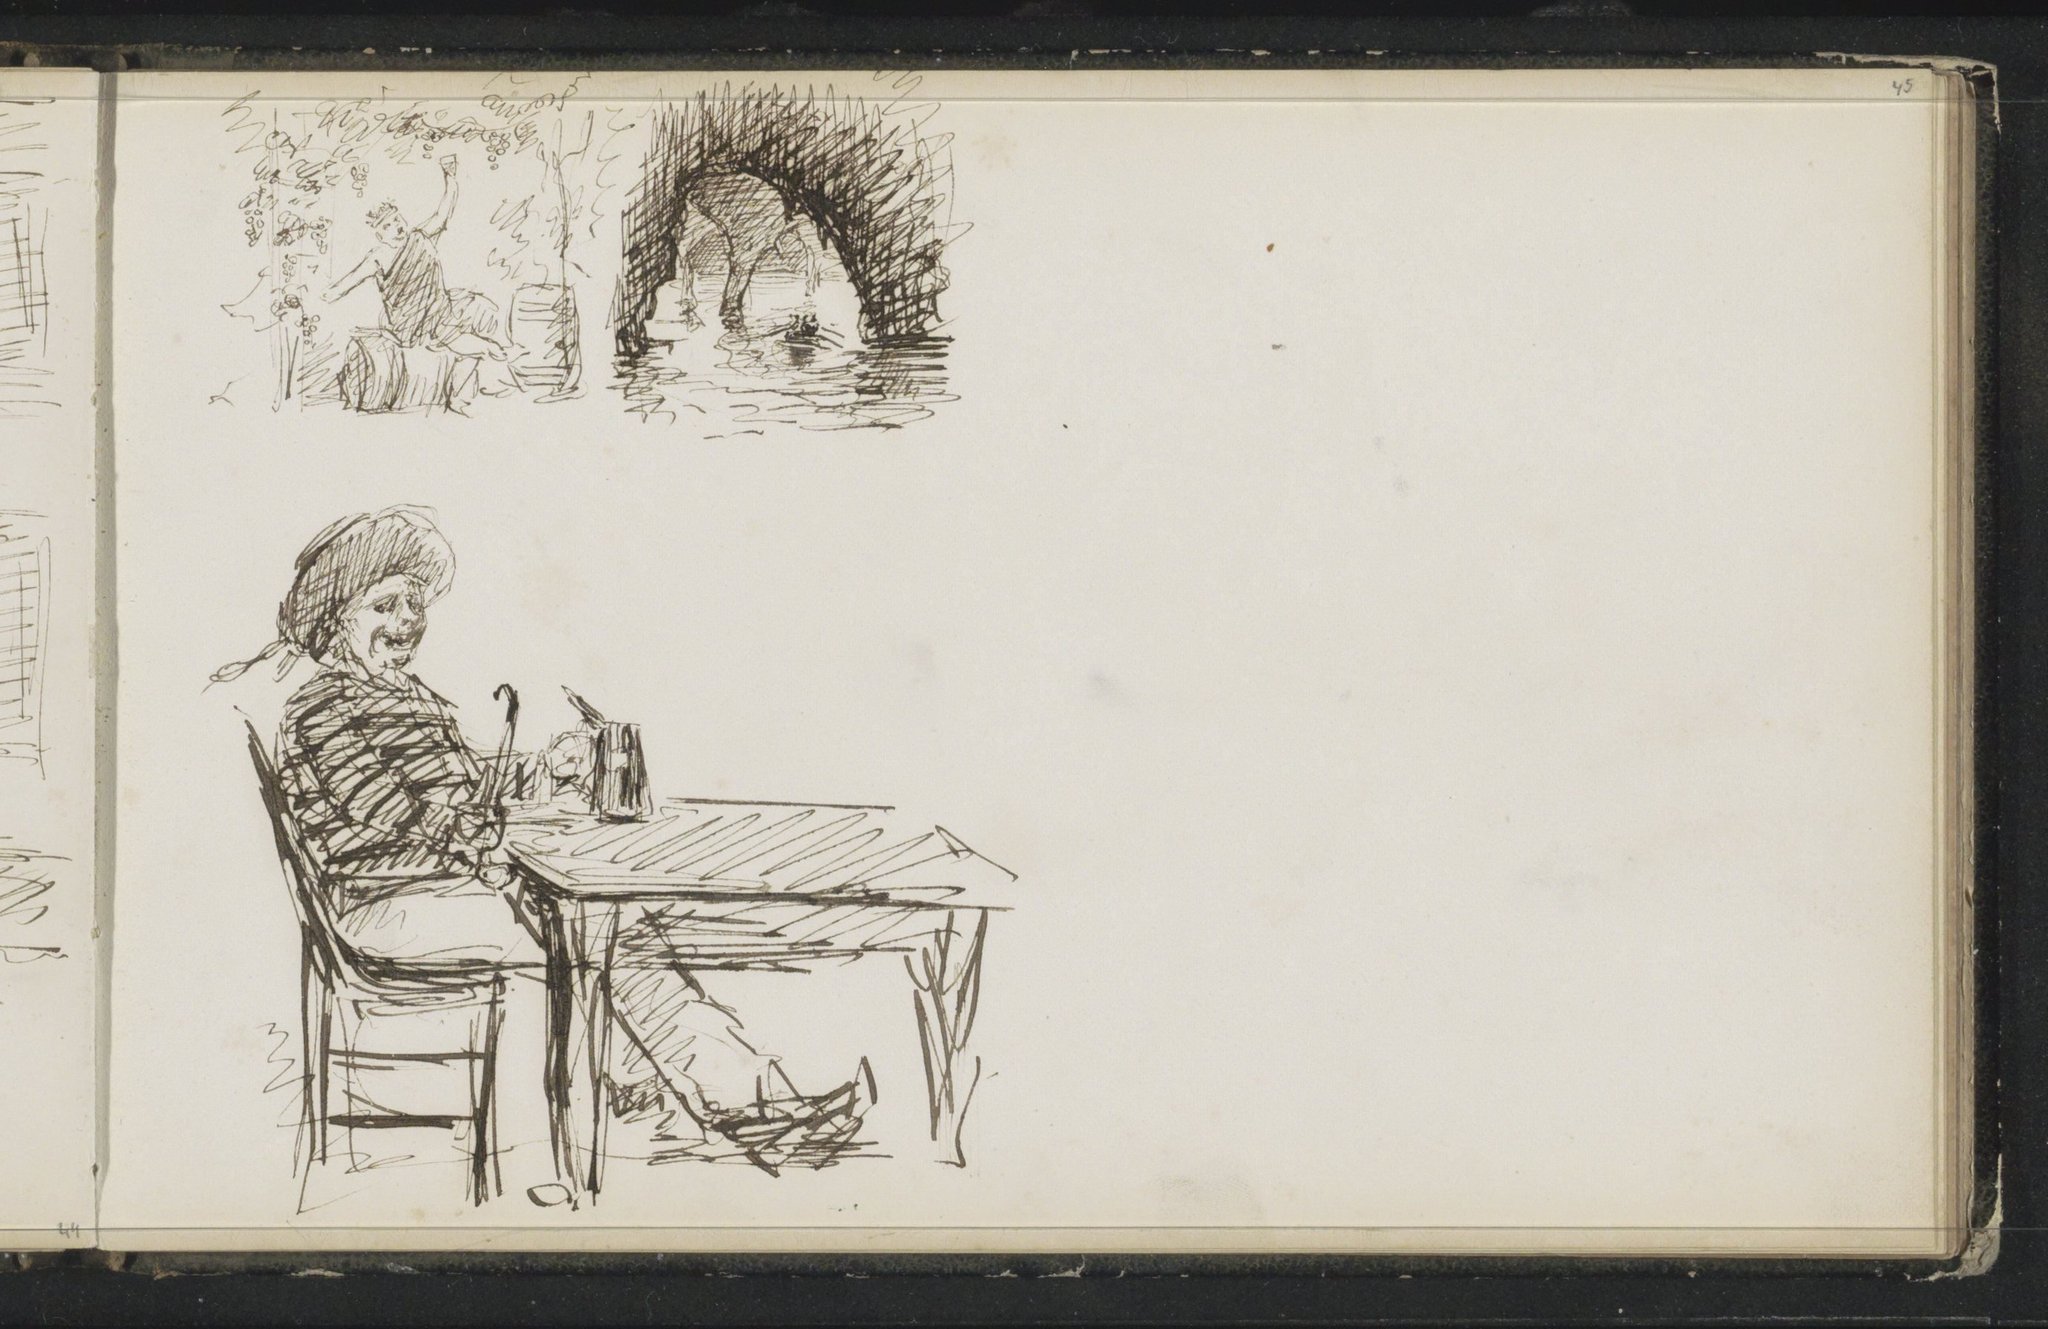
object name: sketchbook leaf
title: Man met een pijp aan een tafel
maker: marius bauer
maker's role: draughtsman, print maker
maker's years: 1867-1932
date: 1812-1880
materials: paper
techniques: pen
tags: sitting figure, adult man, pipe ~ tobacco, cup, table, rowing-boat, canoe, etc., cave, grotto, the drunken bacchus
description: De man draagt een hoed en heeft een kroes, mogelijk met drank, in zijn linkerhand. Tevens studies van een Bacchusfiguur in een wijngaard en van een roeiboot bij een grot. Pagina 45 uit een schetsboek met 34 bladen.